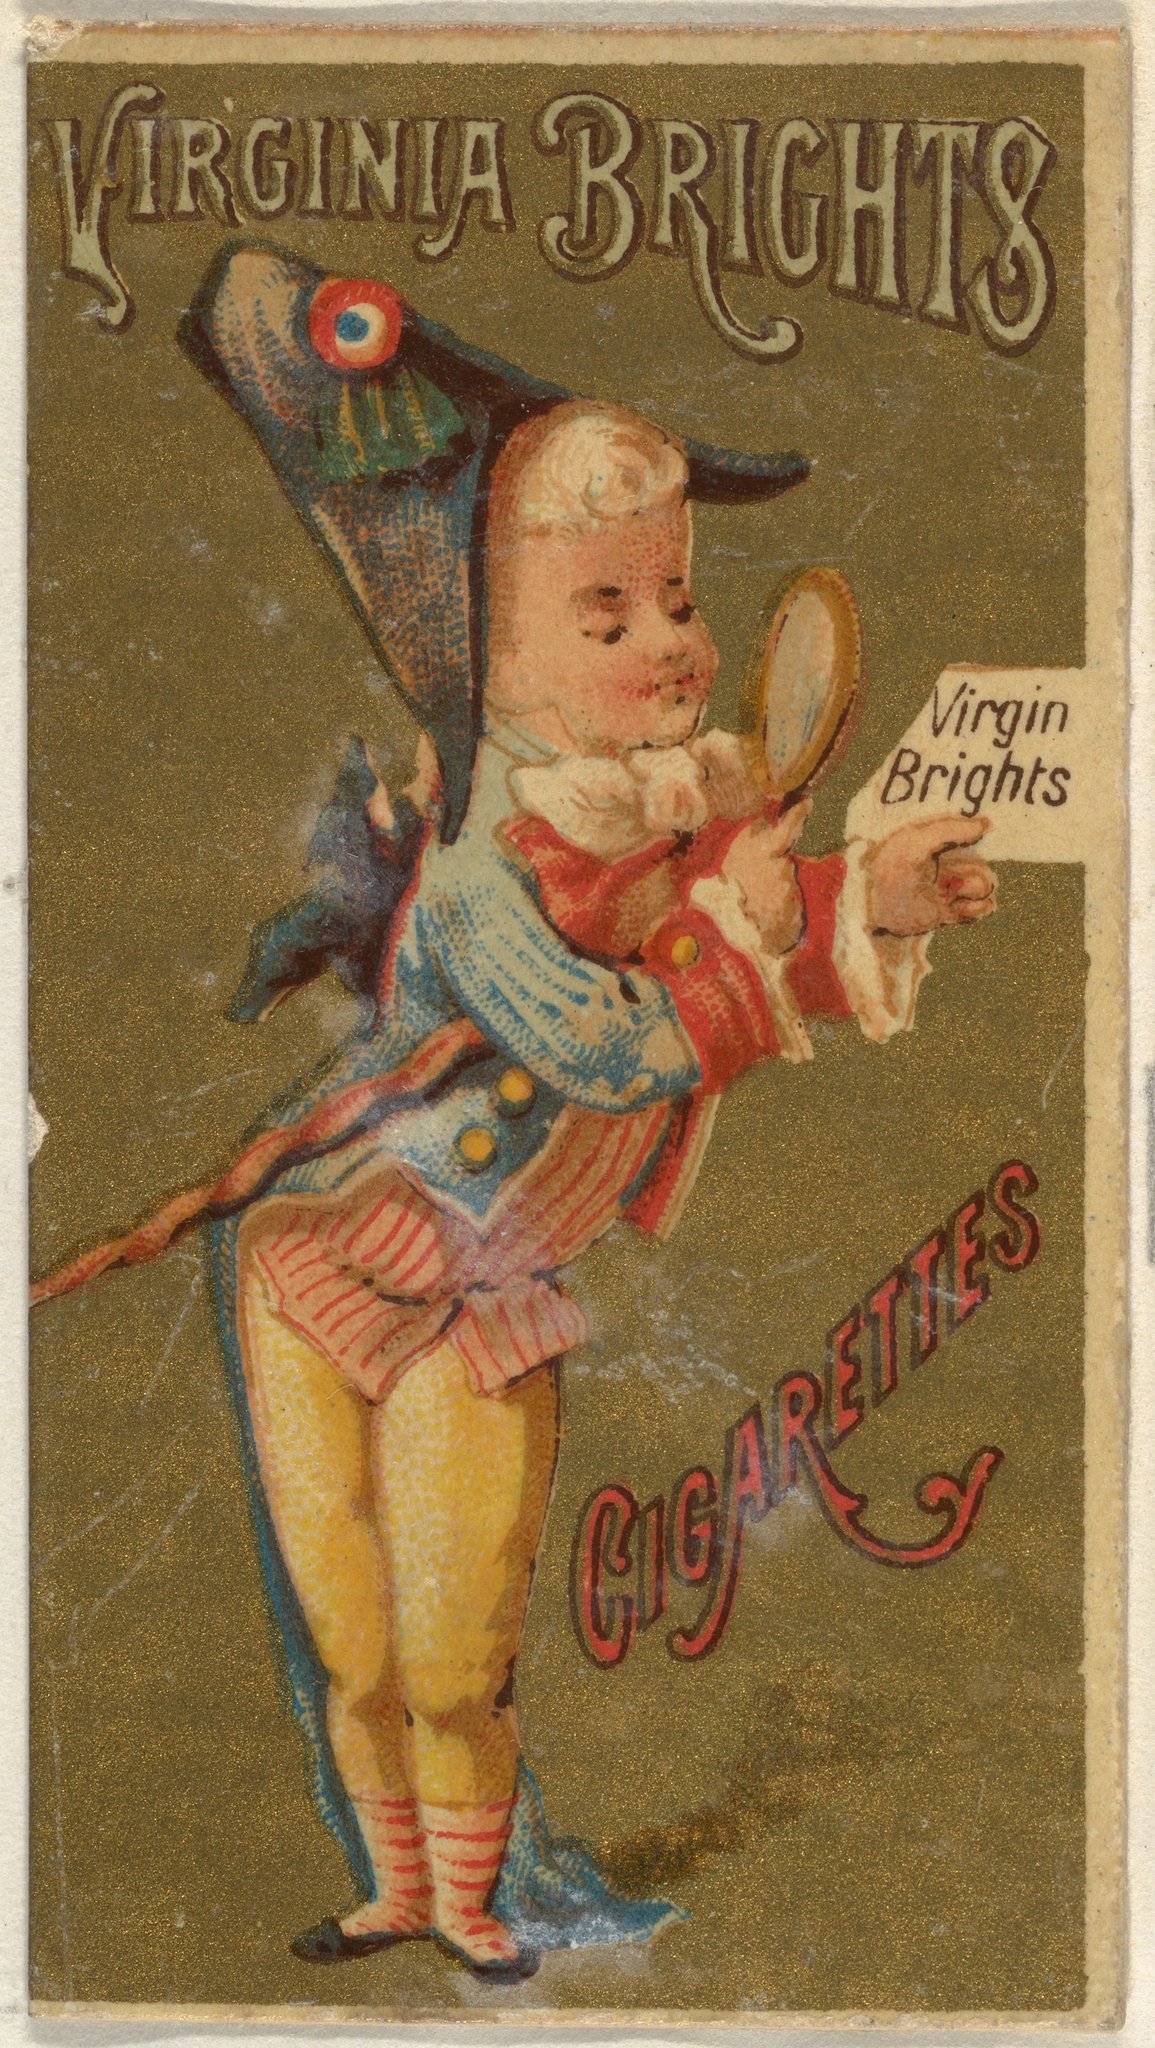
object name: print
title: From the Girls and Children series (N64) promoting Virginia Brights Cigarettes for Allen & Ginter brand tobacco products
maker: allen & ginter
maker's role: publisher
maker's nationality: american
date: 1886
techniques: color lithograph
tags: girls